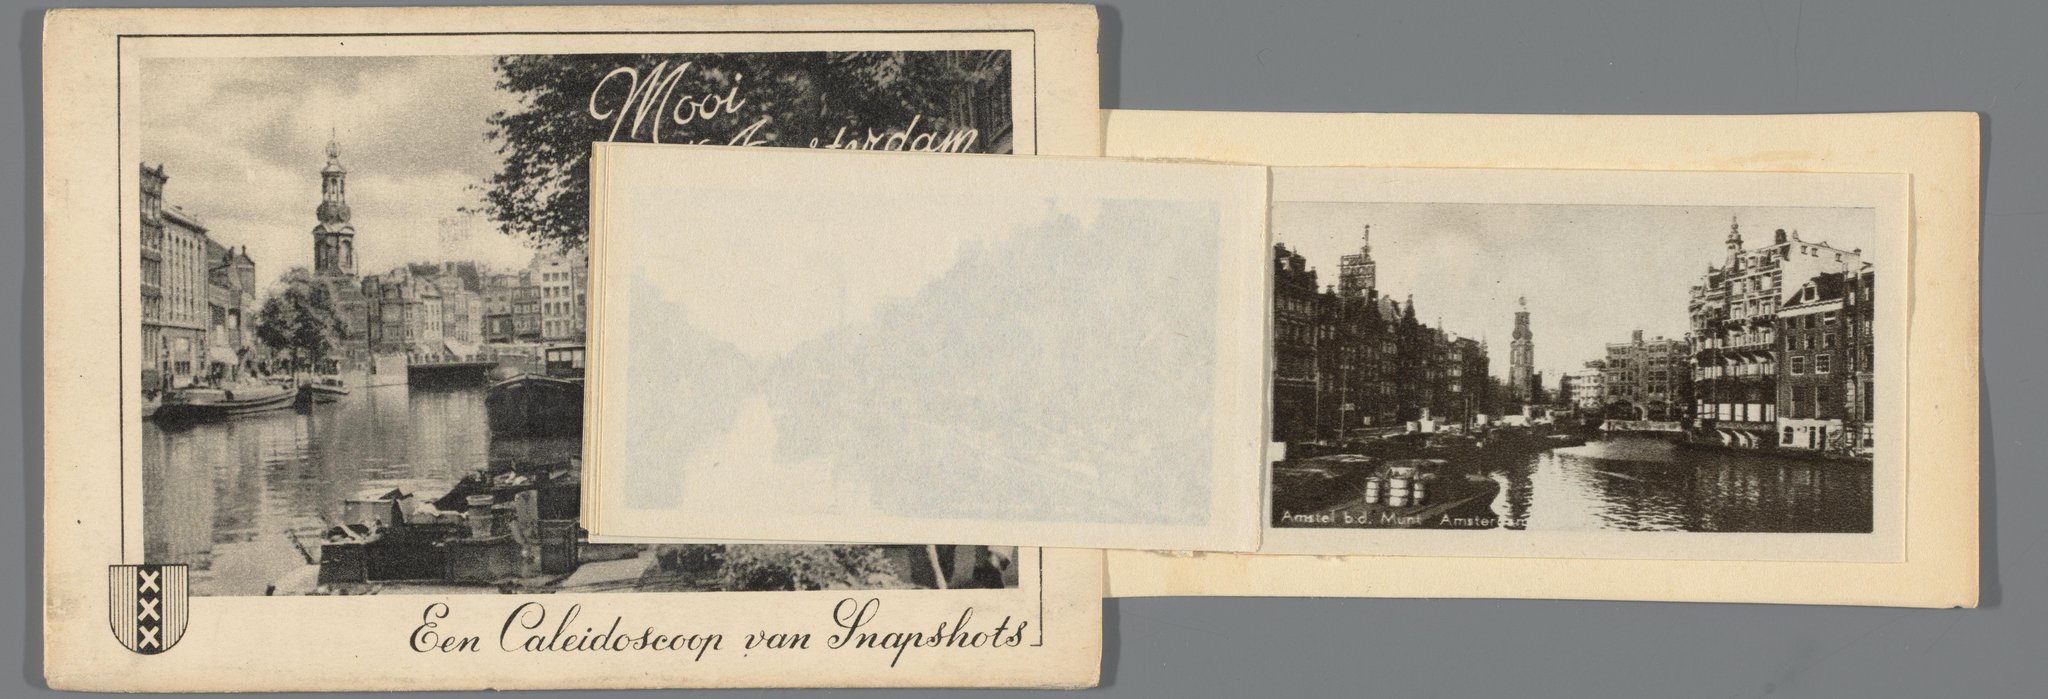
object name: photomechanical print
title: Munt Amsterdam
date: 1920-1950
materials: paper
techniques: rotogravure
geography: amsterdam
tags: tower, clock tower ~ monumental adornment, canals, waters (in city)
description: Deze prent maakt deel uit van een omslag met tien prenten.